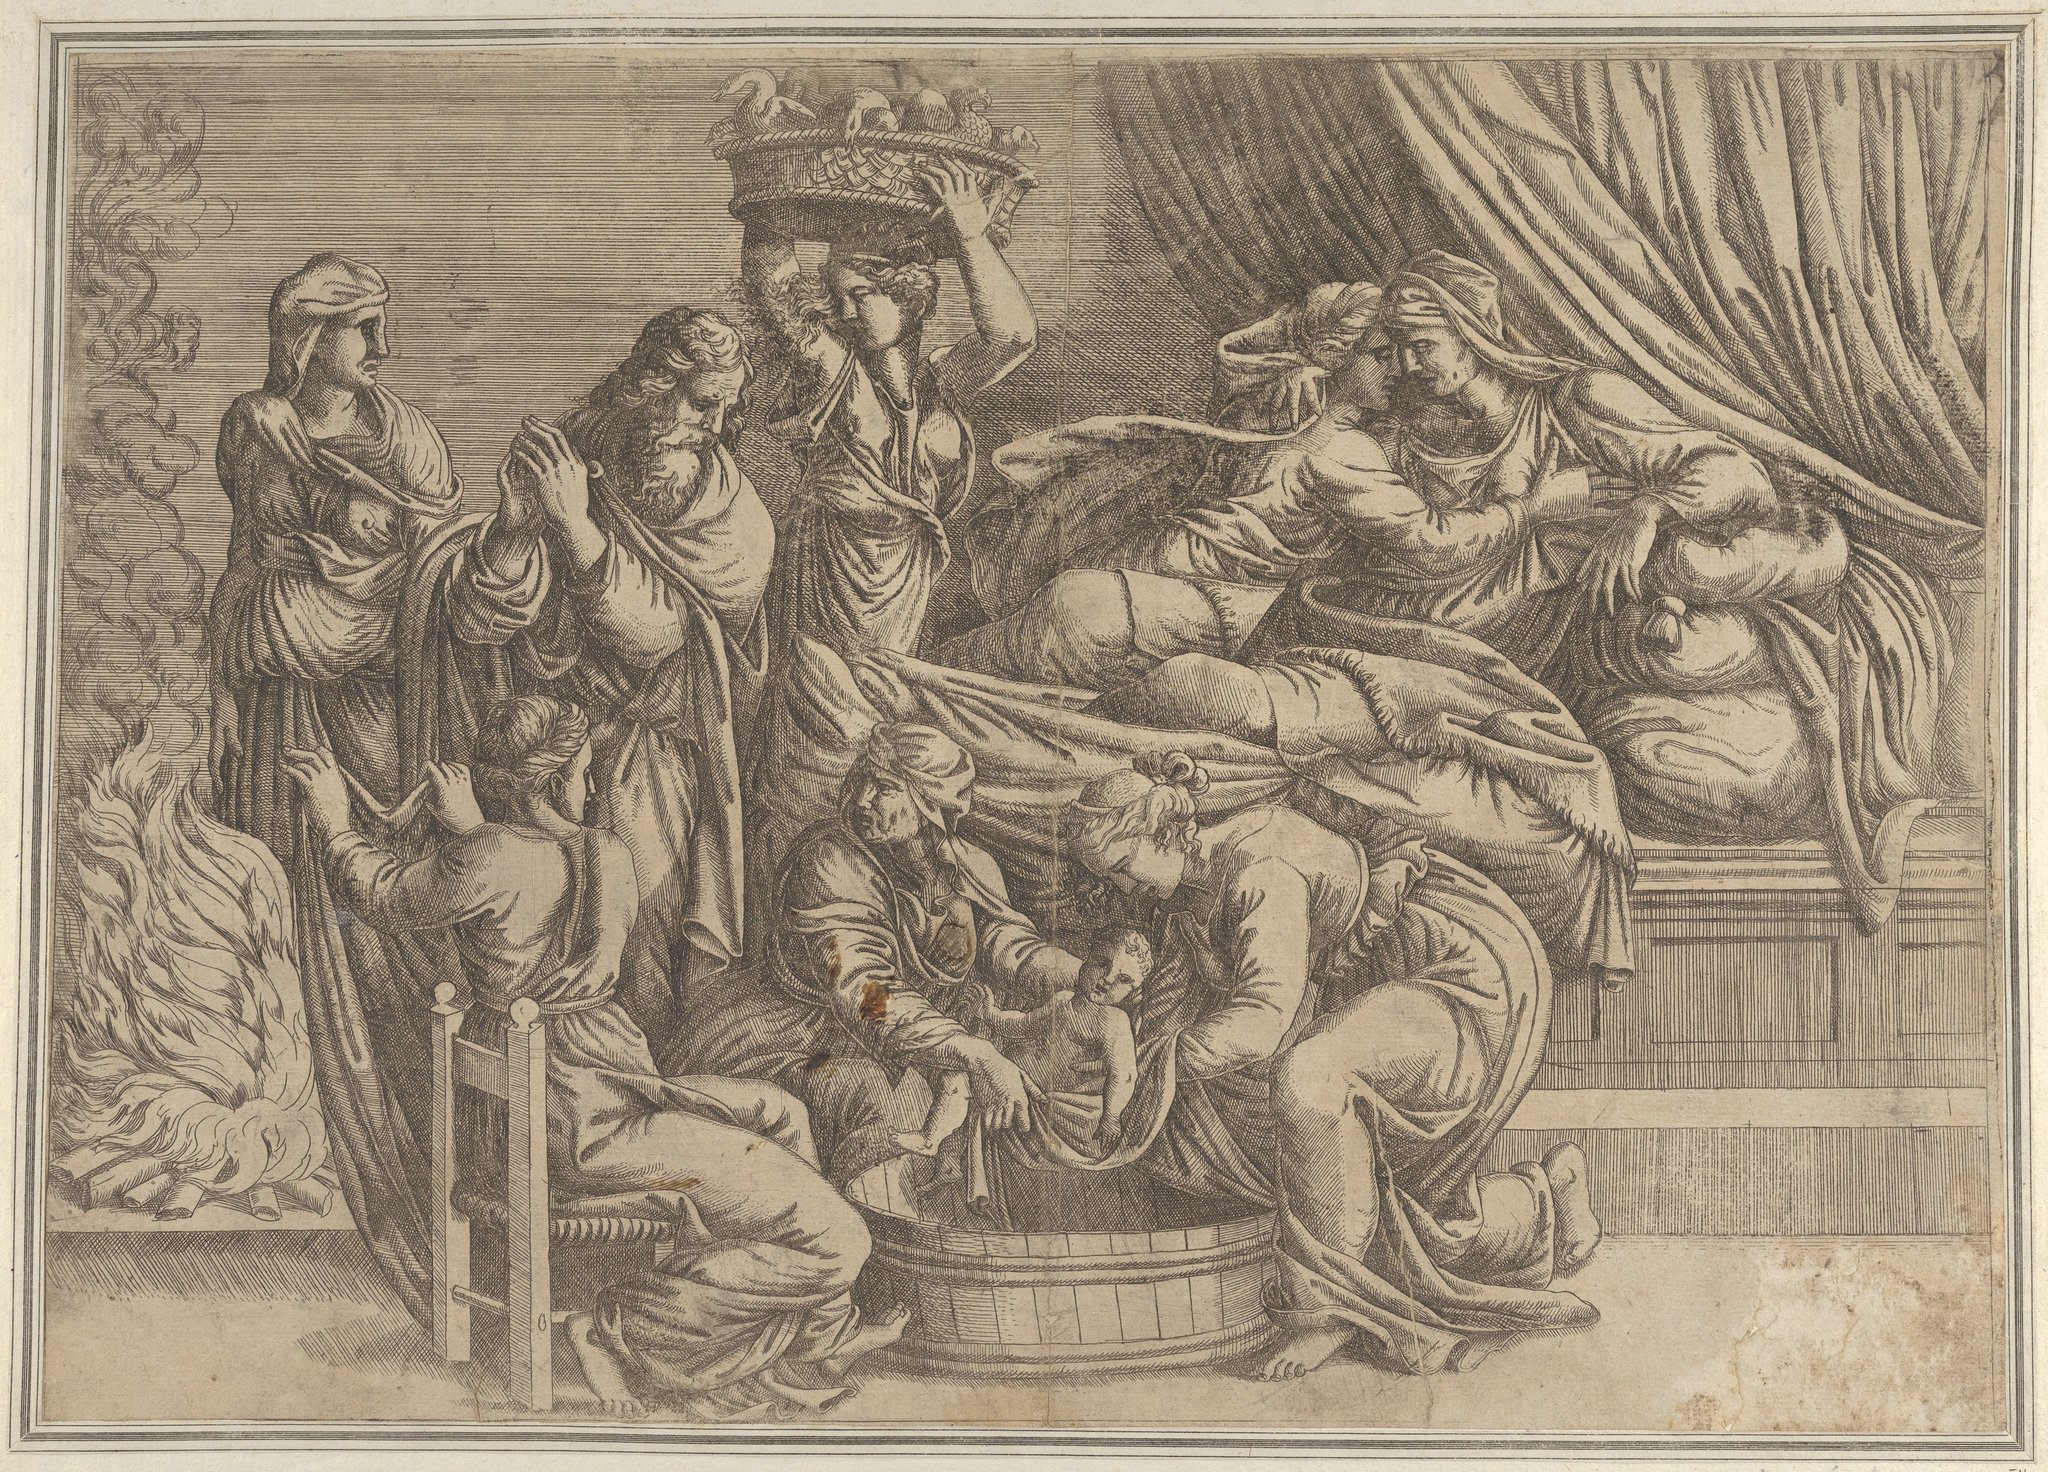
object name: print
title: The Birth of the Virgin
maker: anonymous, french, school of fontainebleau, 16th century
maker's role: artist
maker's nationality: french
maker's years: 1500-1600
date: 1501-1600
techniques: etching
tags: men,women,virgin mary,birth